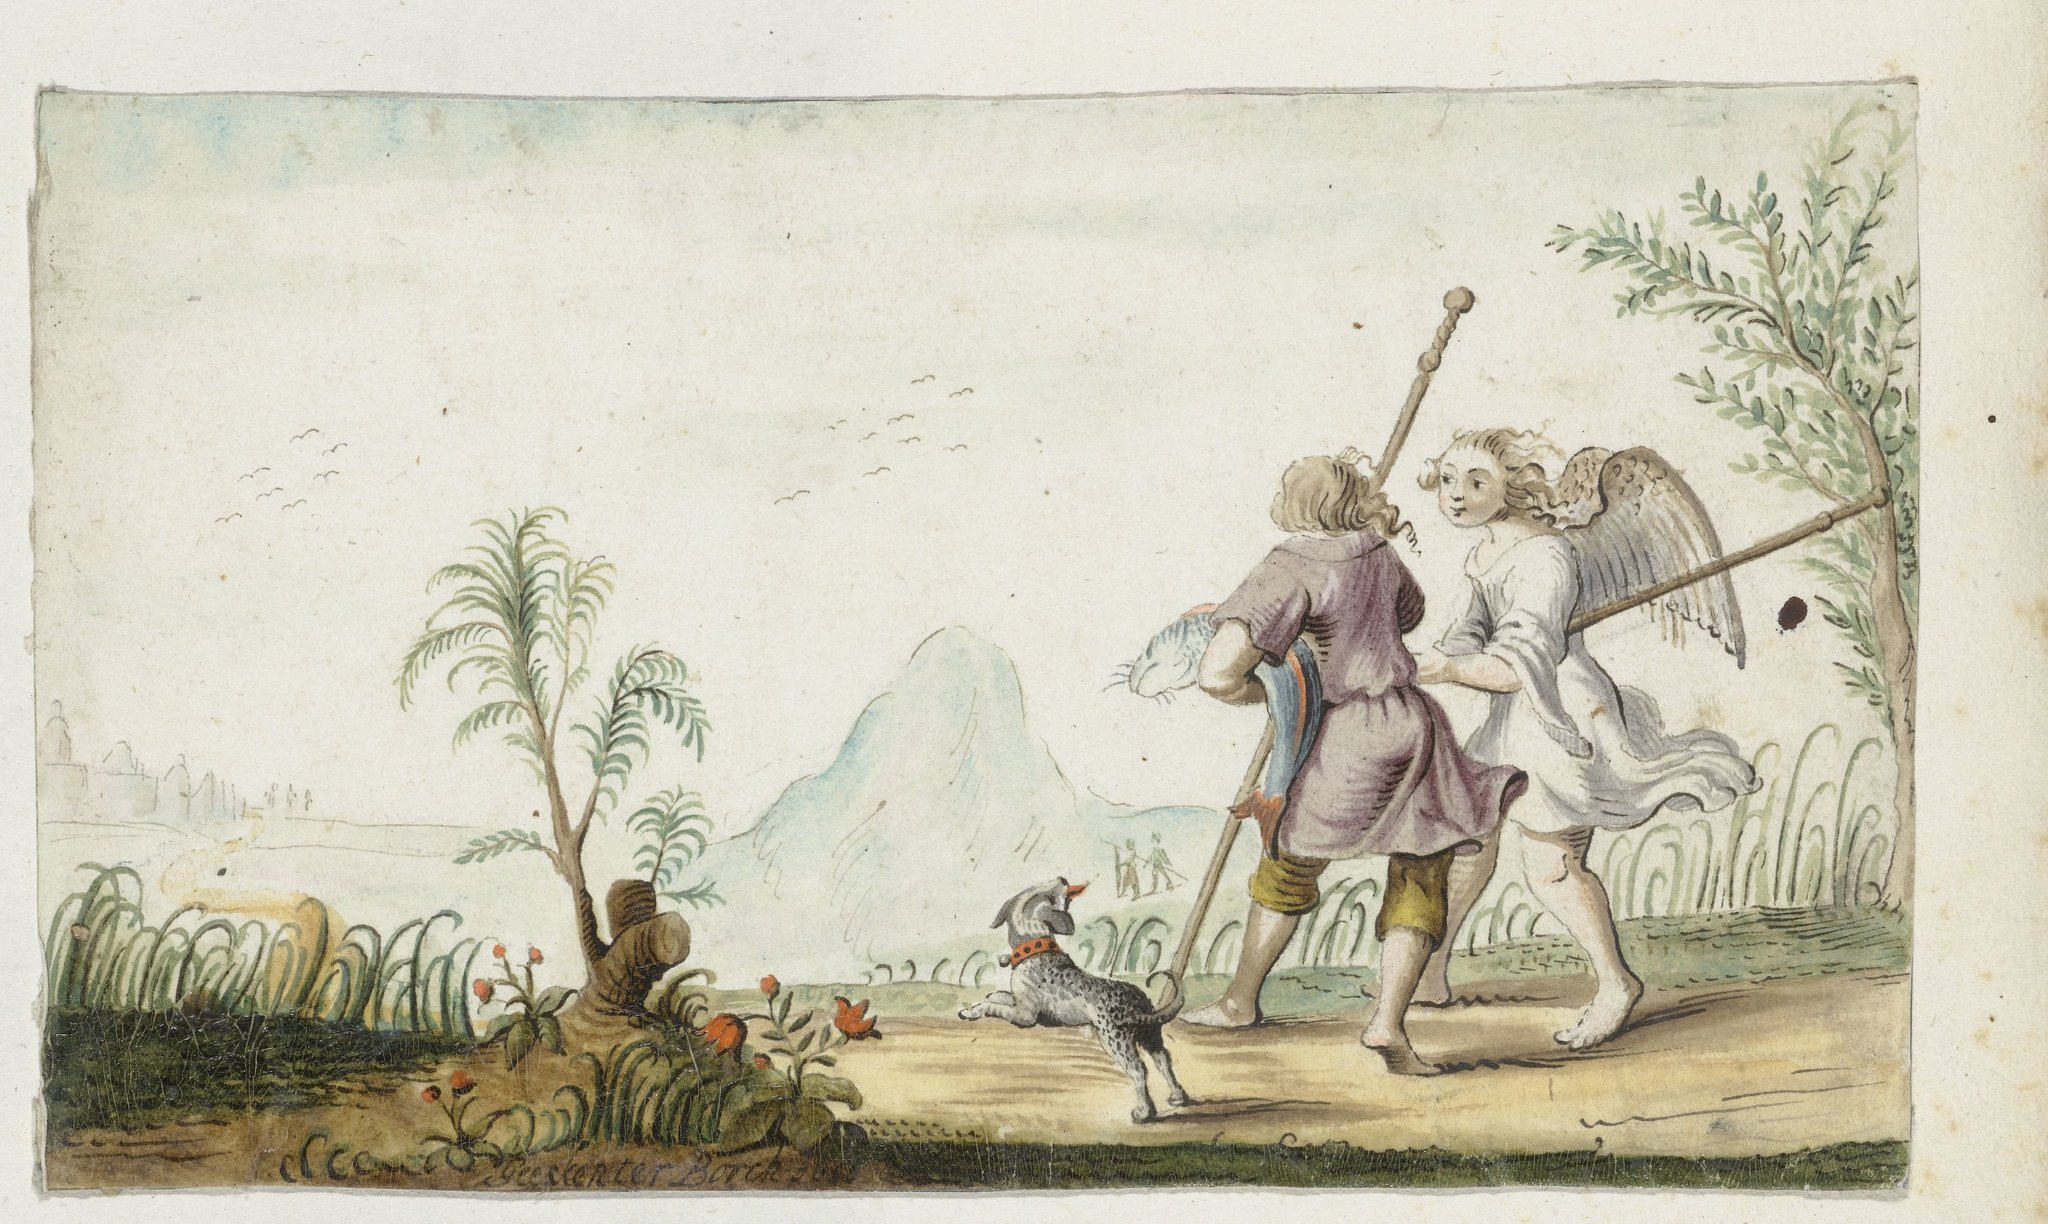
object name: drawing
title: Tobias en de engel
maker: gesina ter borch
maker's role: draughtsman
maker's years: 1633-1690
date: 1655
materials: ink, paper, watercolor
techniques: brush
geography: zwolle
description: Tekening naast een andere tekening in het Familie-plakboek geplakt.